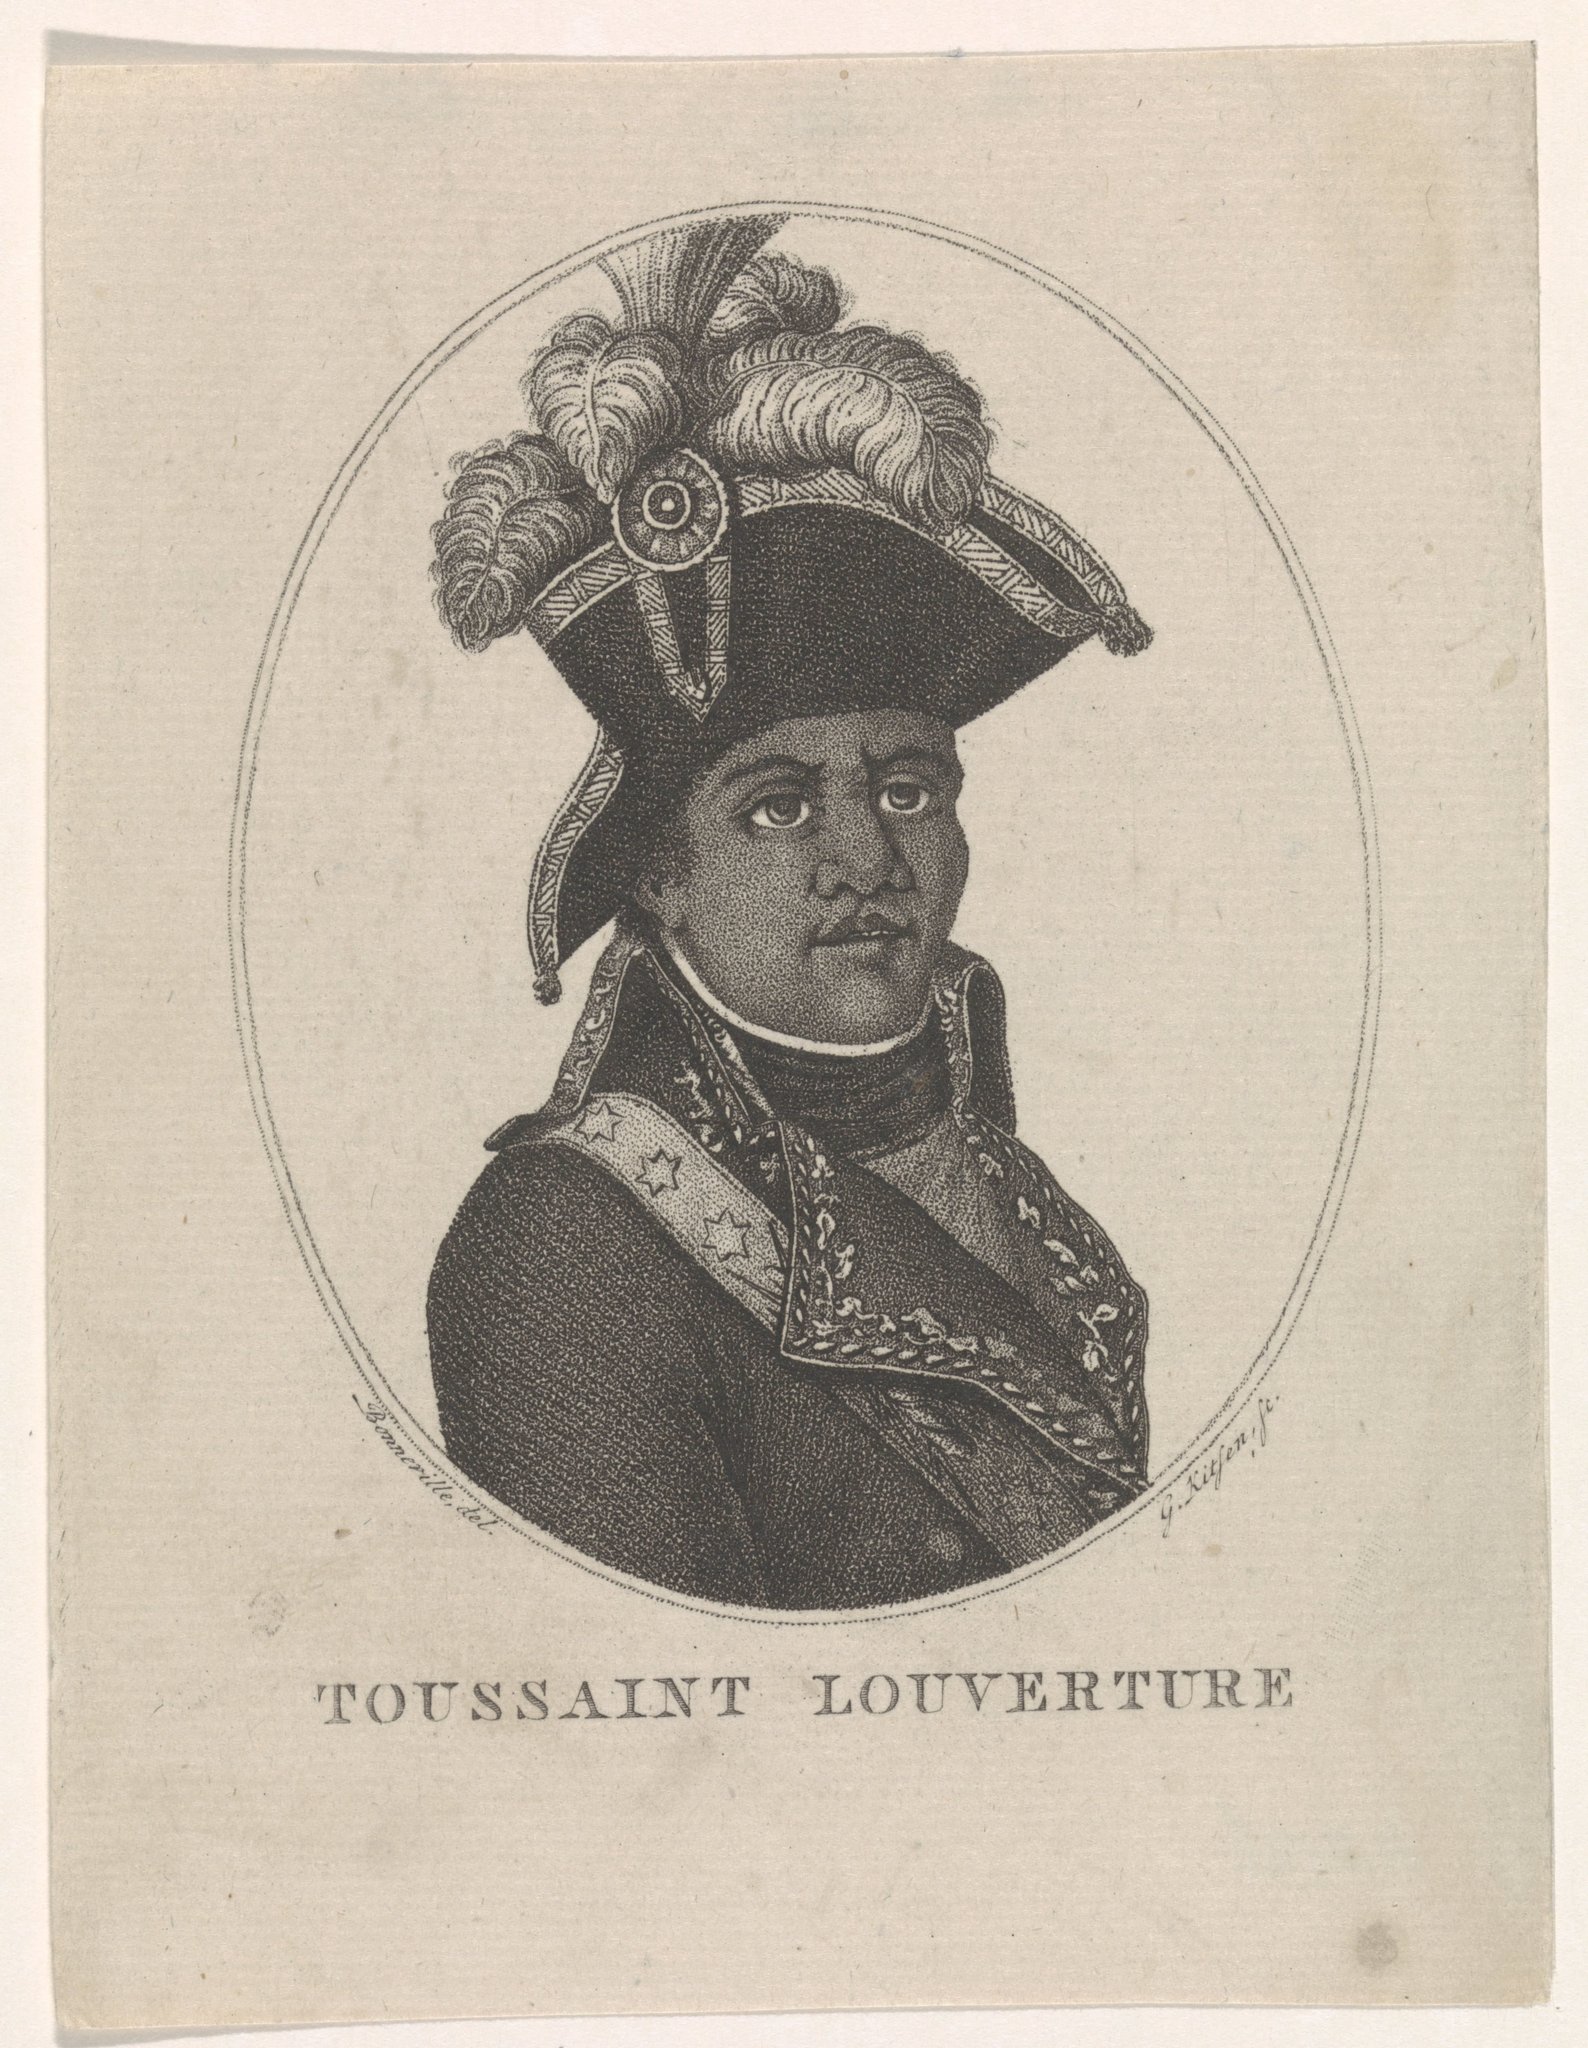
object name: print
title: Portrait Bust of Toussaint L’Ouverture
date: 1802-1810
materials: paper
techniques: etching, engraving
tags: françois-dominique toussaint louverture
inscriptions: collector's mark: Lugt 2228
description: In the late 18th and early 19th centuries, many portraits of Toussaint L’Ouverture and other Black revolutionaries were made in France. This Dutch print is after a French example from 1802. Unlike Toussaint, Tula was not to be remembered. The colonial government tried to completely erase Tula’s existence. It is only in the last 50 years that Tula has been commemorated as a symbol against slavery.